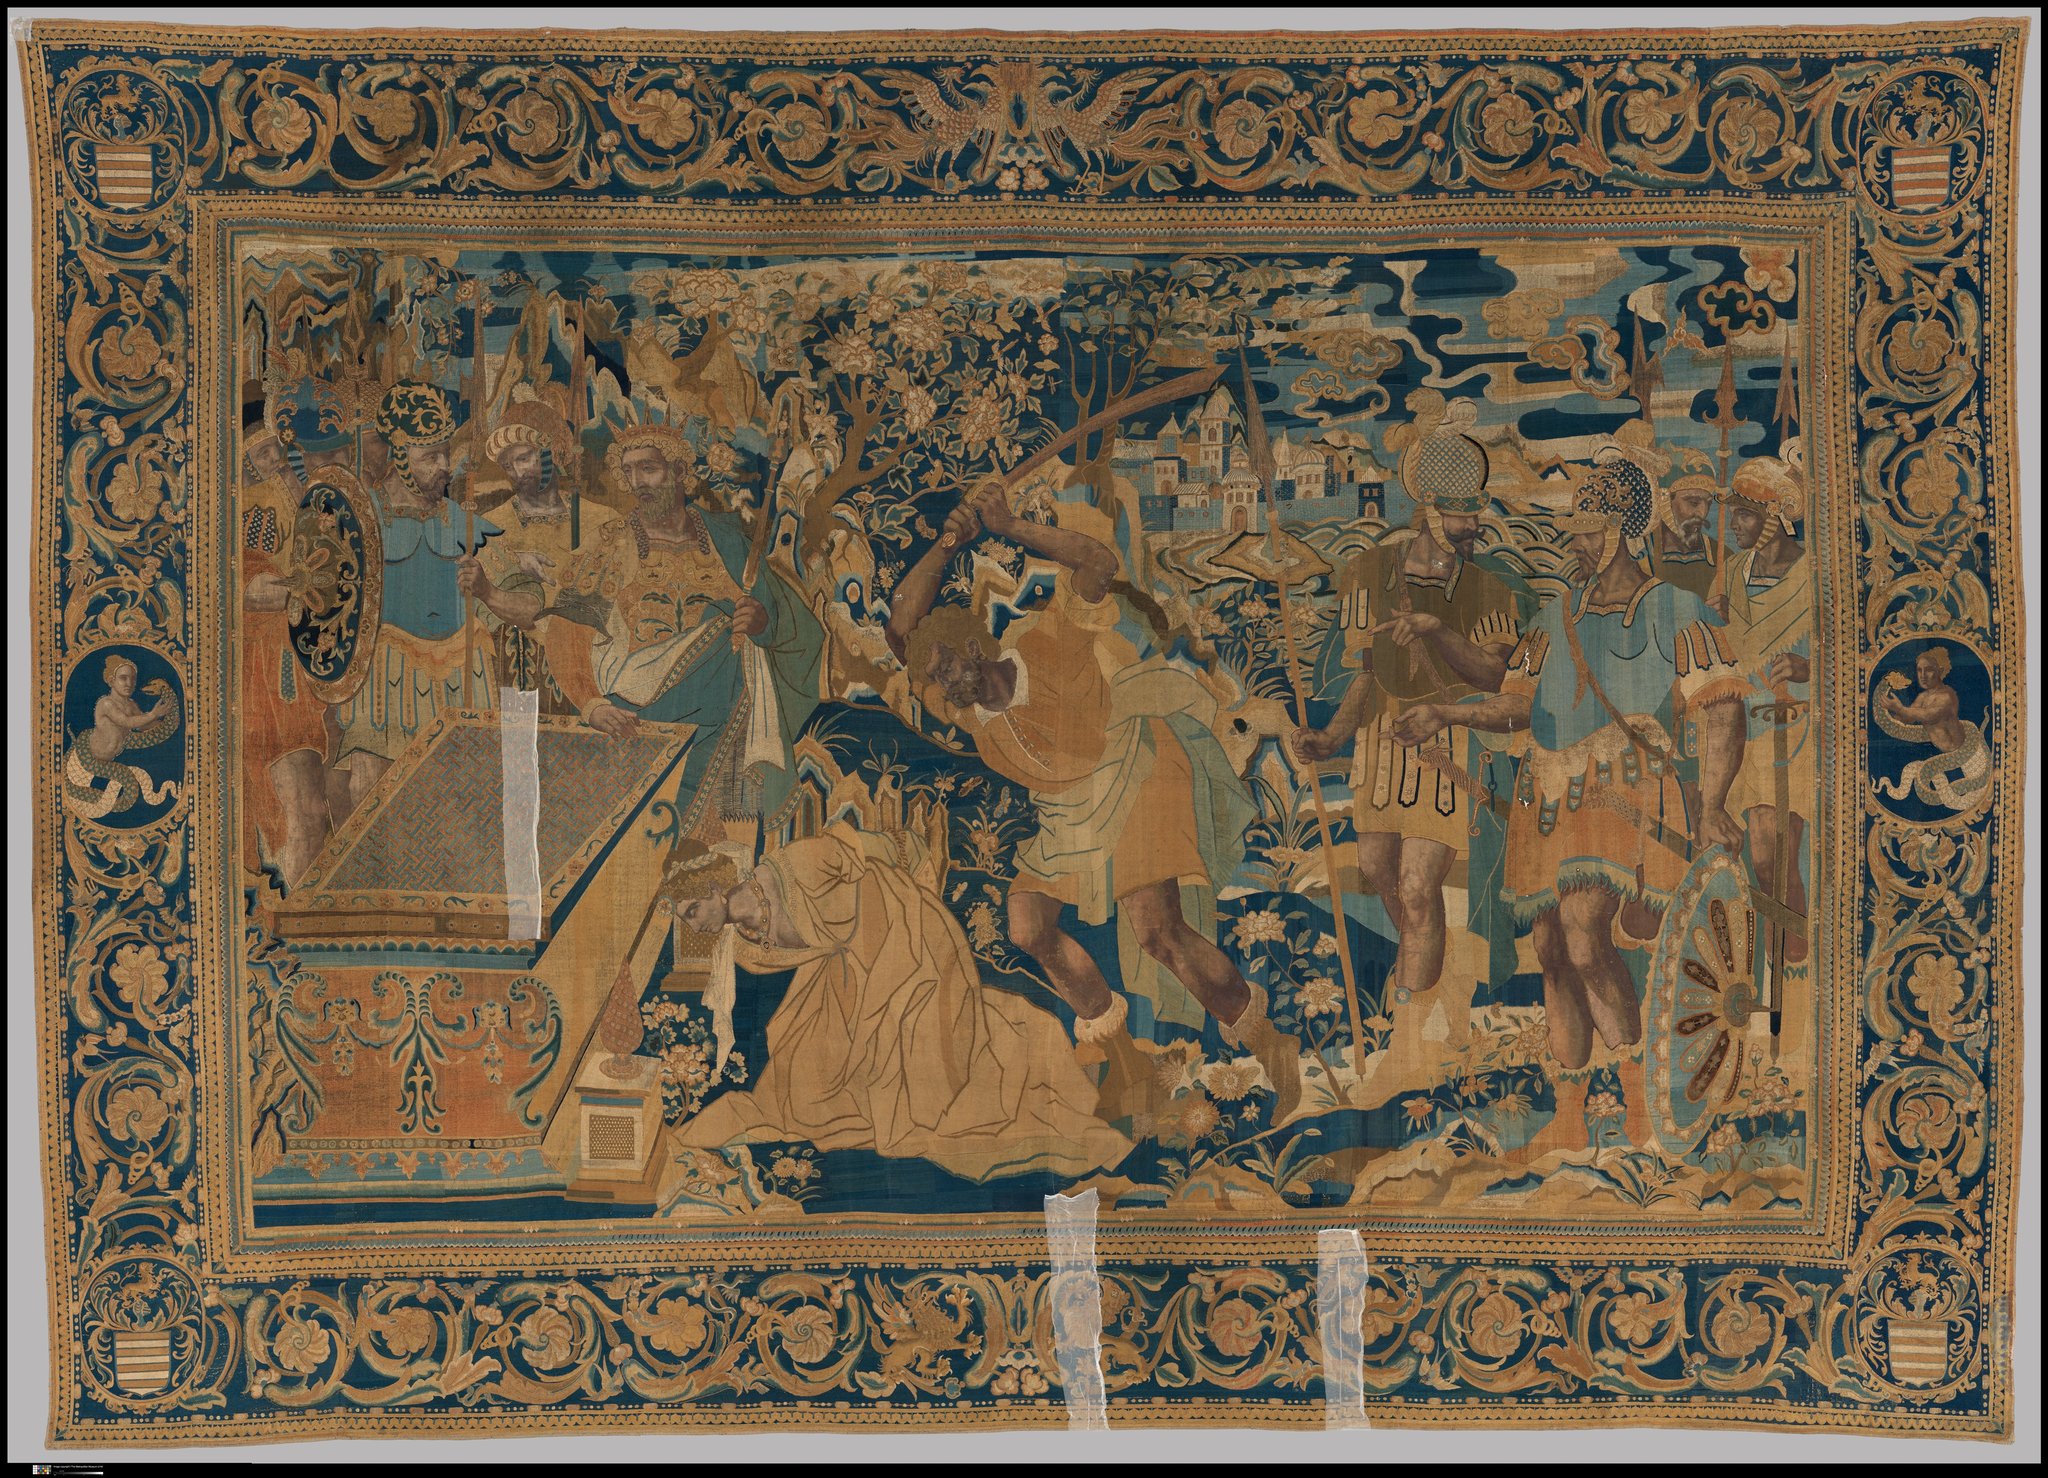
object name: hanging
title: The Sacrifice of Polyxena from a set of The Story of Troy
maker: bernard salomon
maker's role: artist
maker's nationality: french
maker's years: 1508-1561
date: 1625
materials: cotton, gilt, paper, pigment, silk, thread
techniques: embroidery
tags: trojan war,men,women